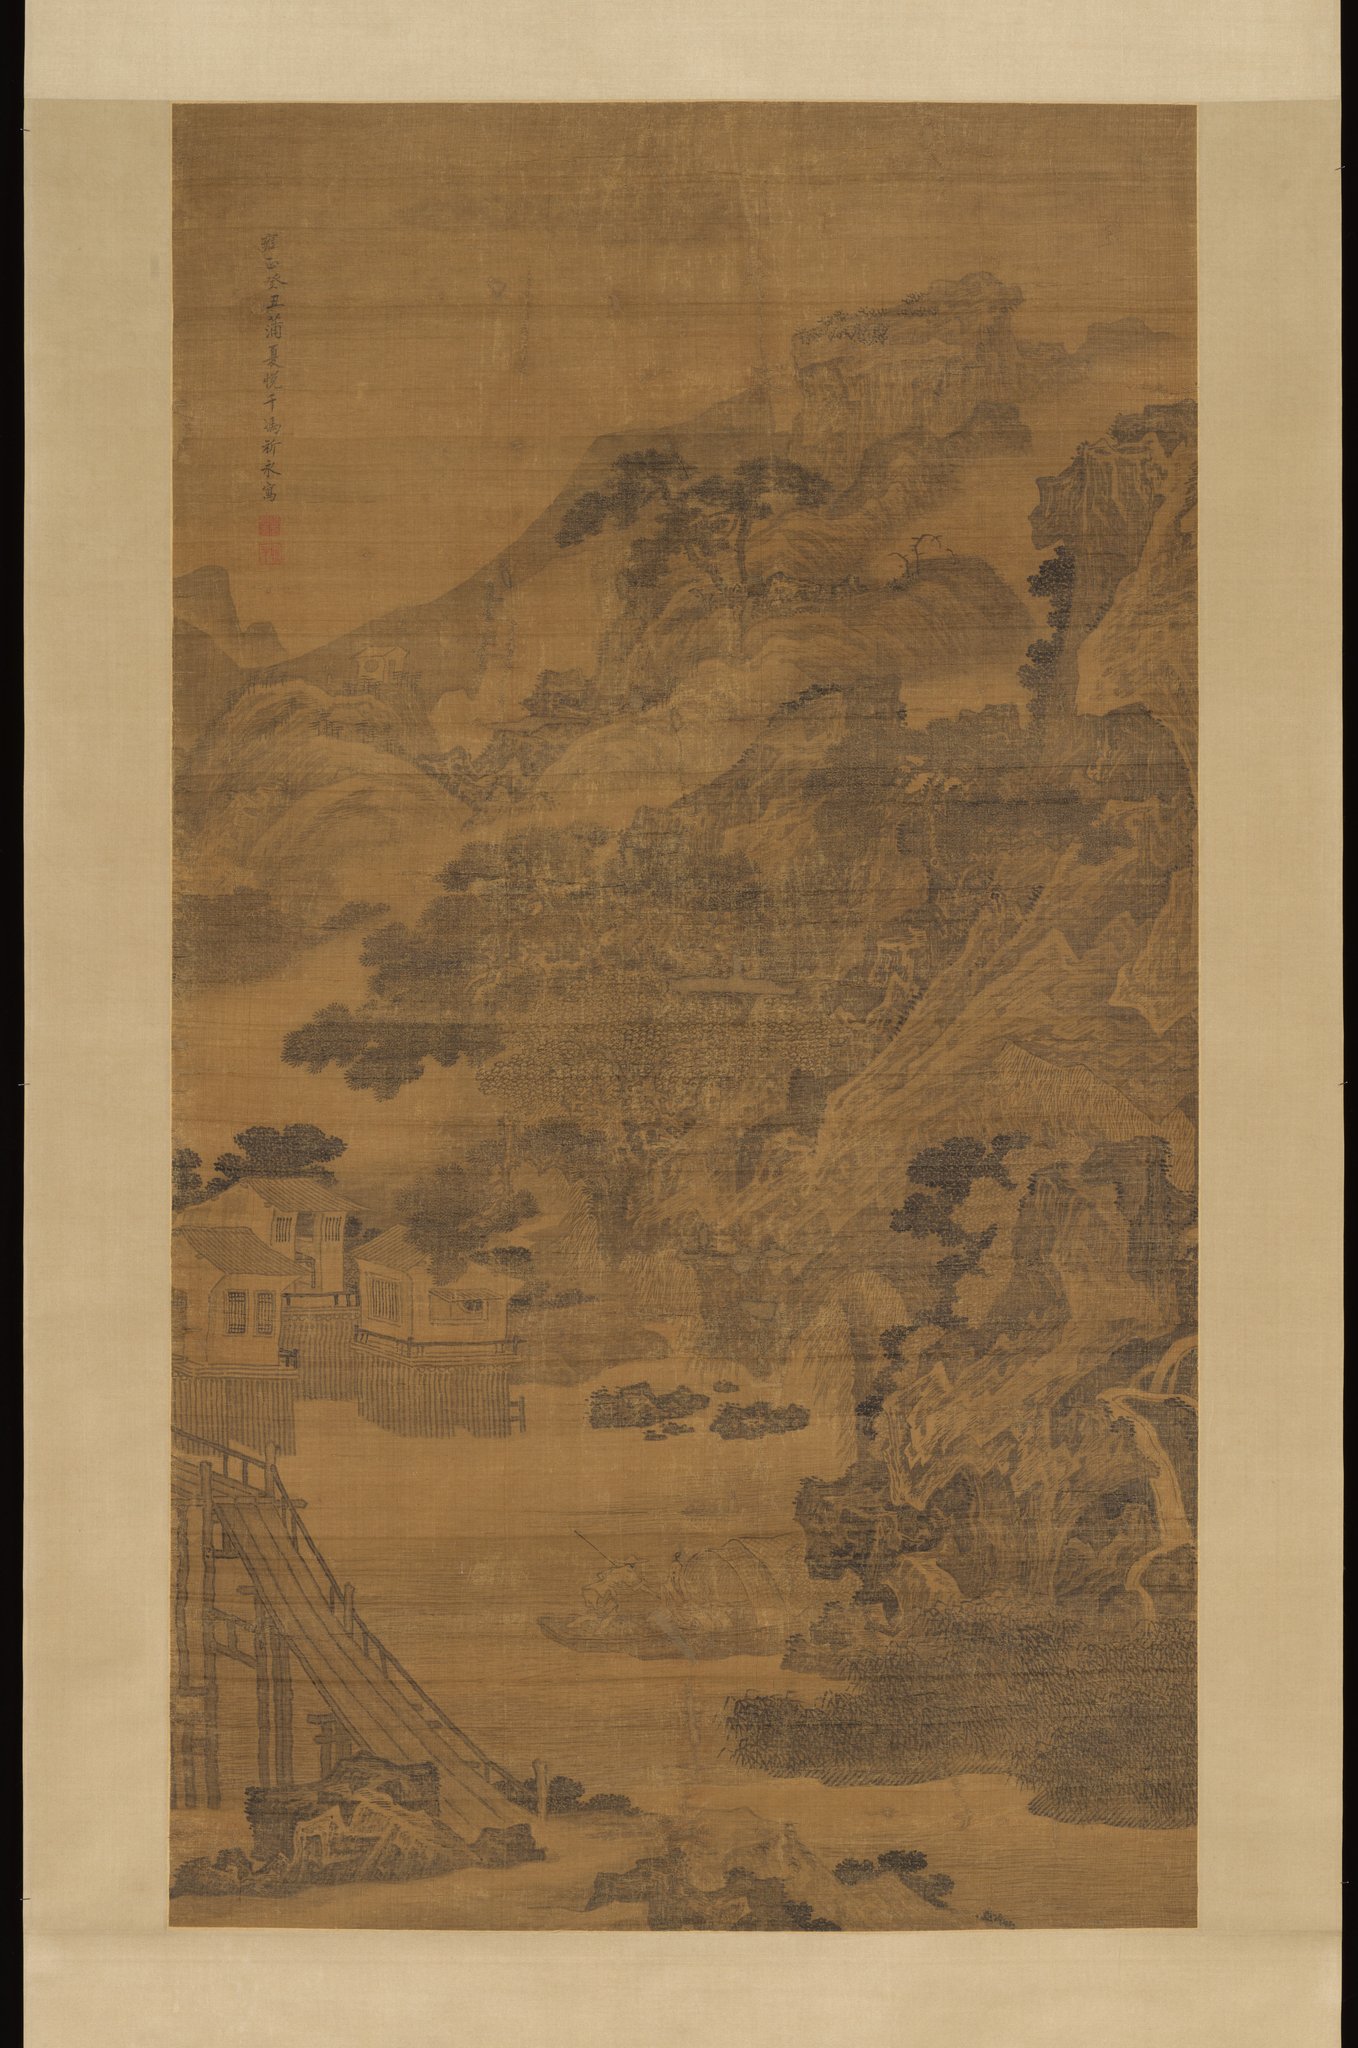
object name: hanging scroll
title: Landscape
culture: chinese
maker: feng qiyong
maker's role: artist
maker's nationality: chinese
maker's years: 1730-1739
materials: ink, silk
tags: mountains,landscapes